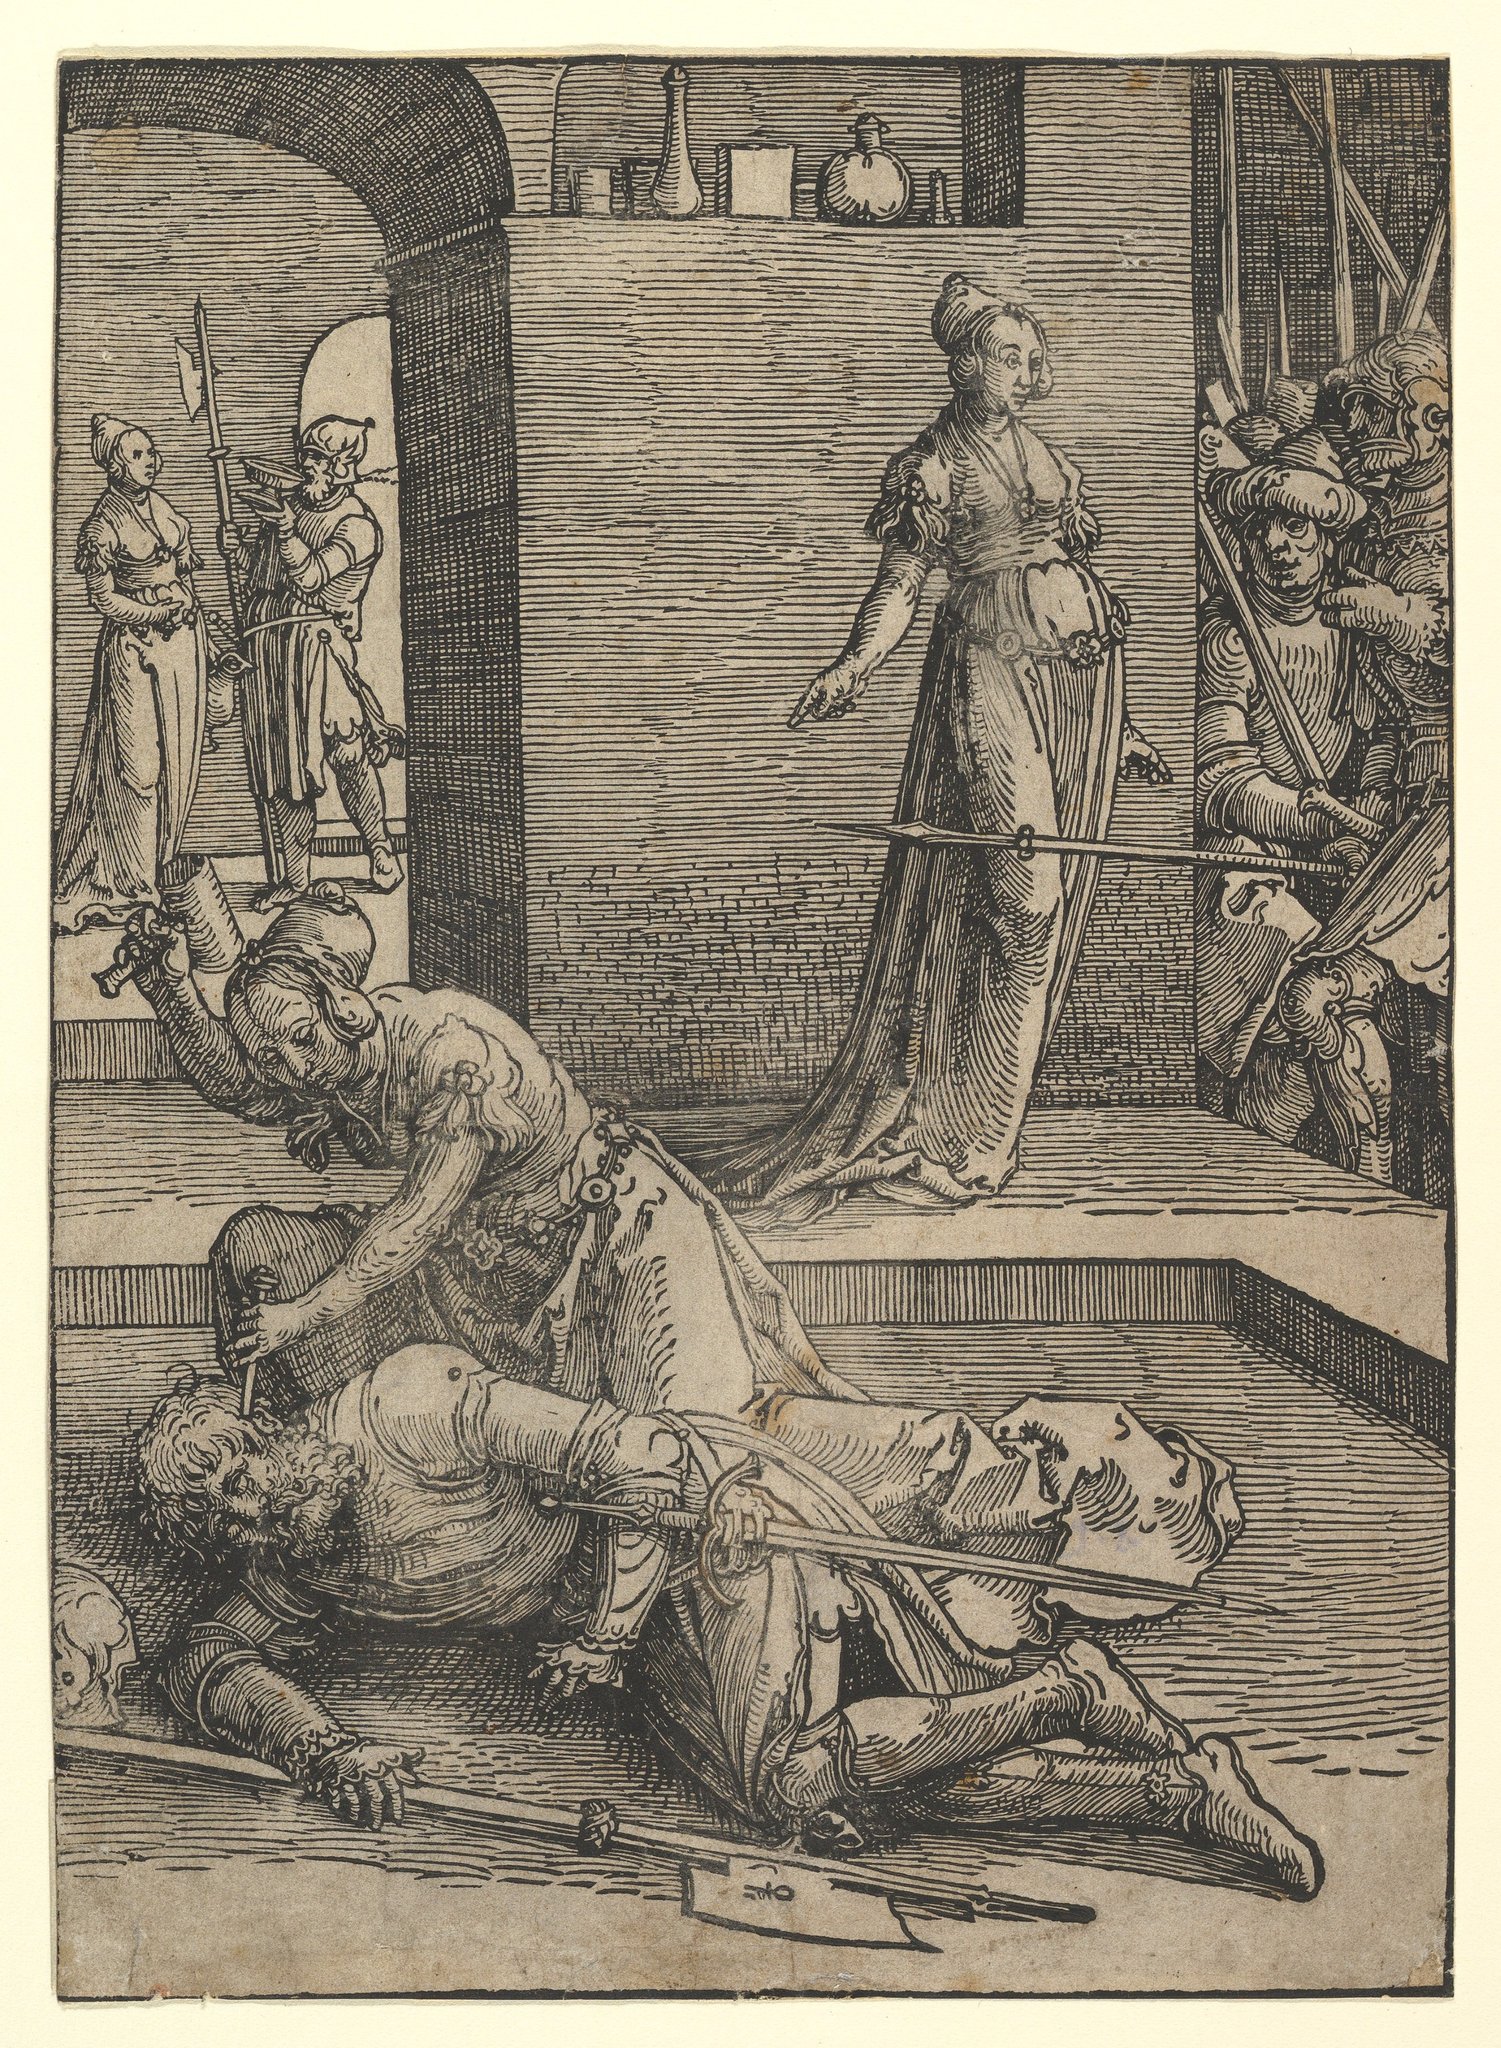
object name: print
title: Jael Killing Sisera, without ornamental frame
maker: lucas van leyden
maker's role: artist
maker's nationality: netherlandish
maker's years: 1494-1533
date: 1517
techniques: woodcut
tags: swords,men,women,death,hammers